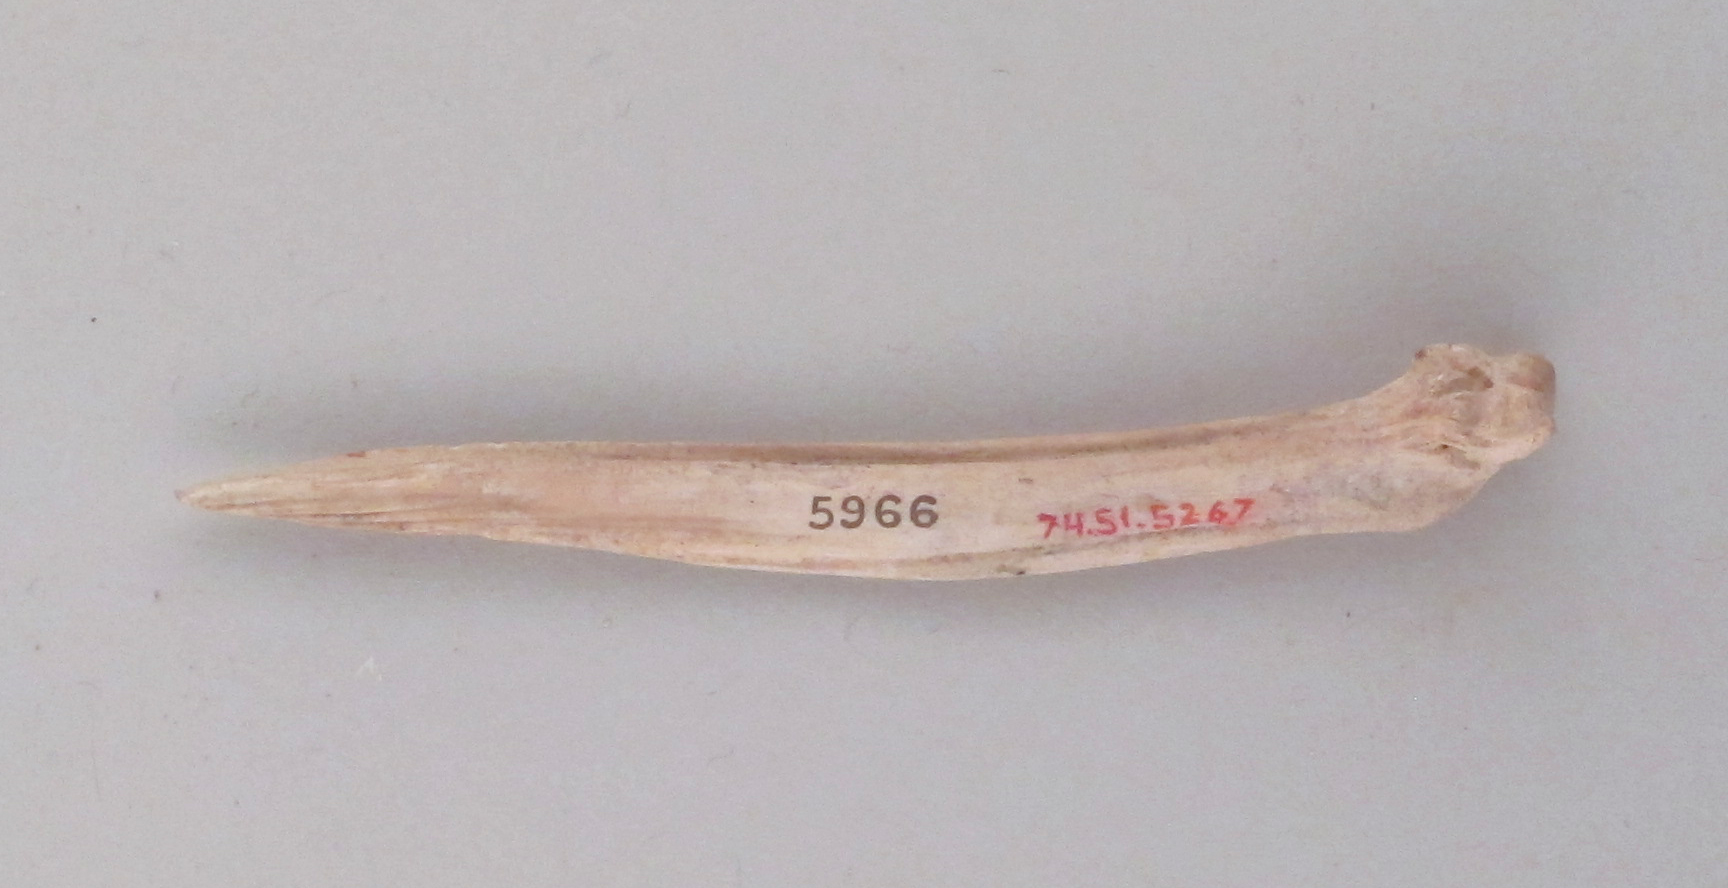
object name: awl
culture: cypriot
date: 3900 BCE-100 CE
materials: bone